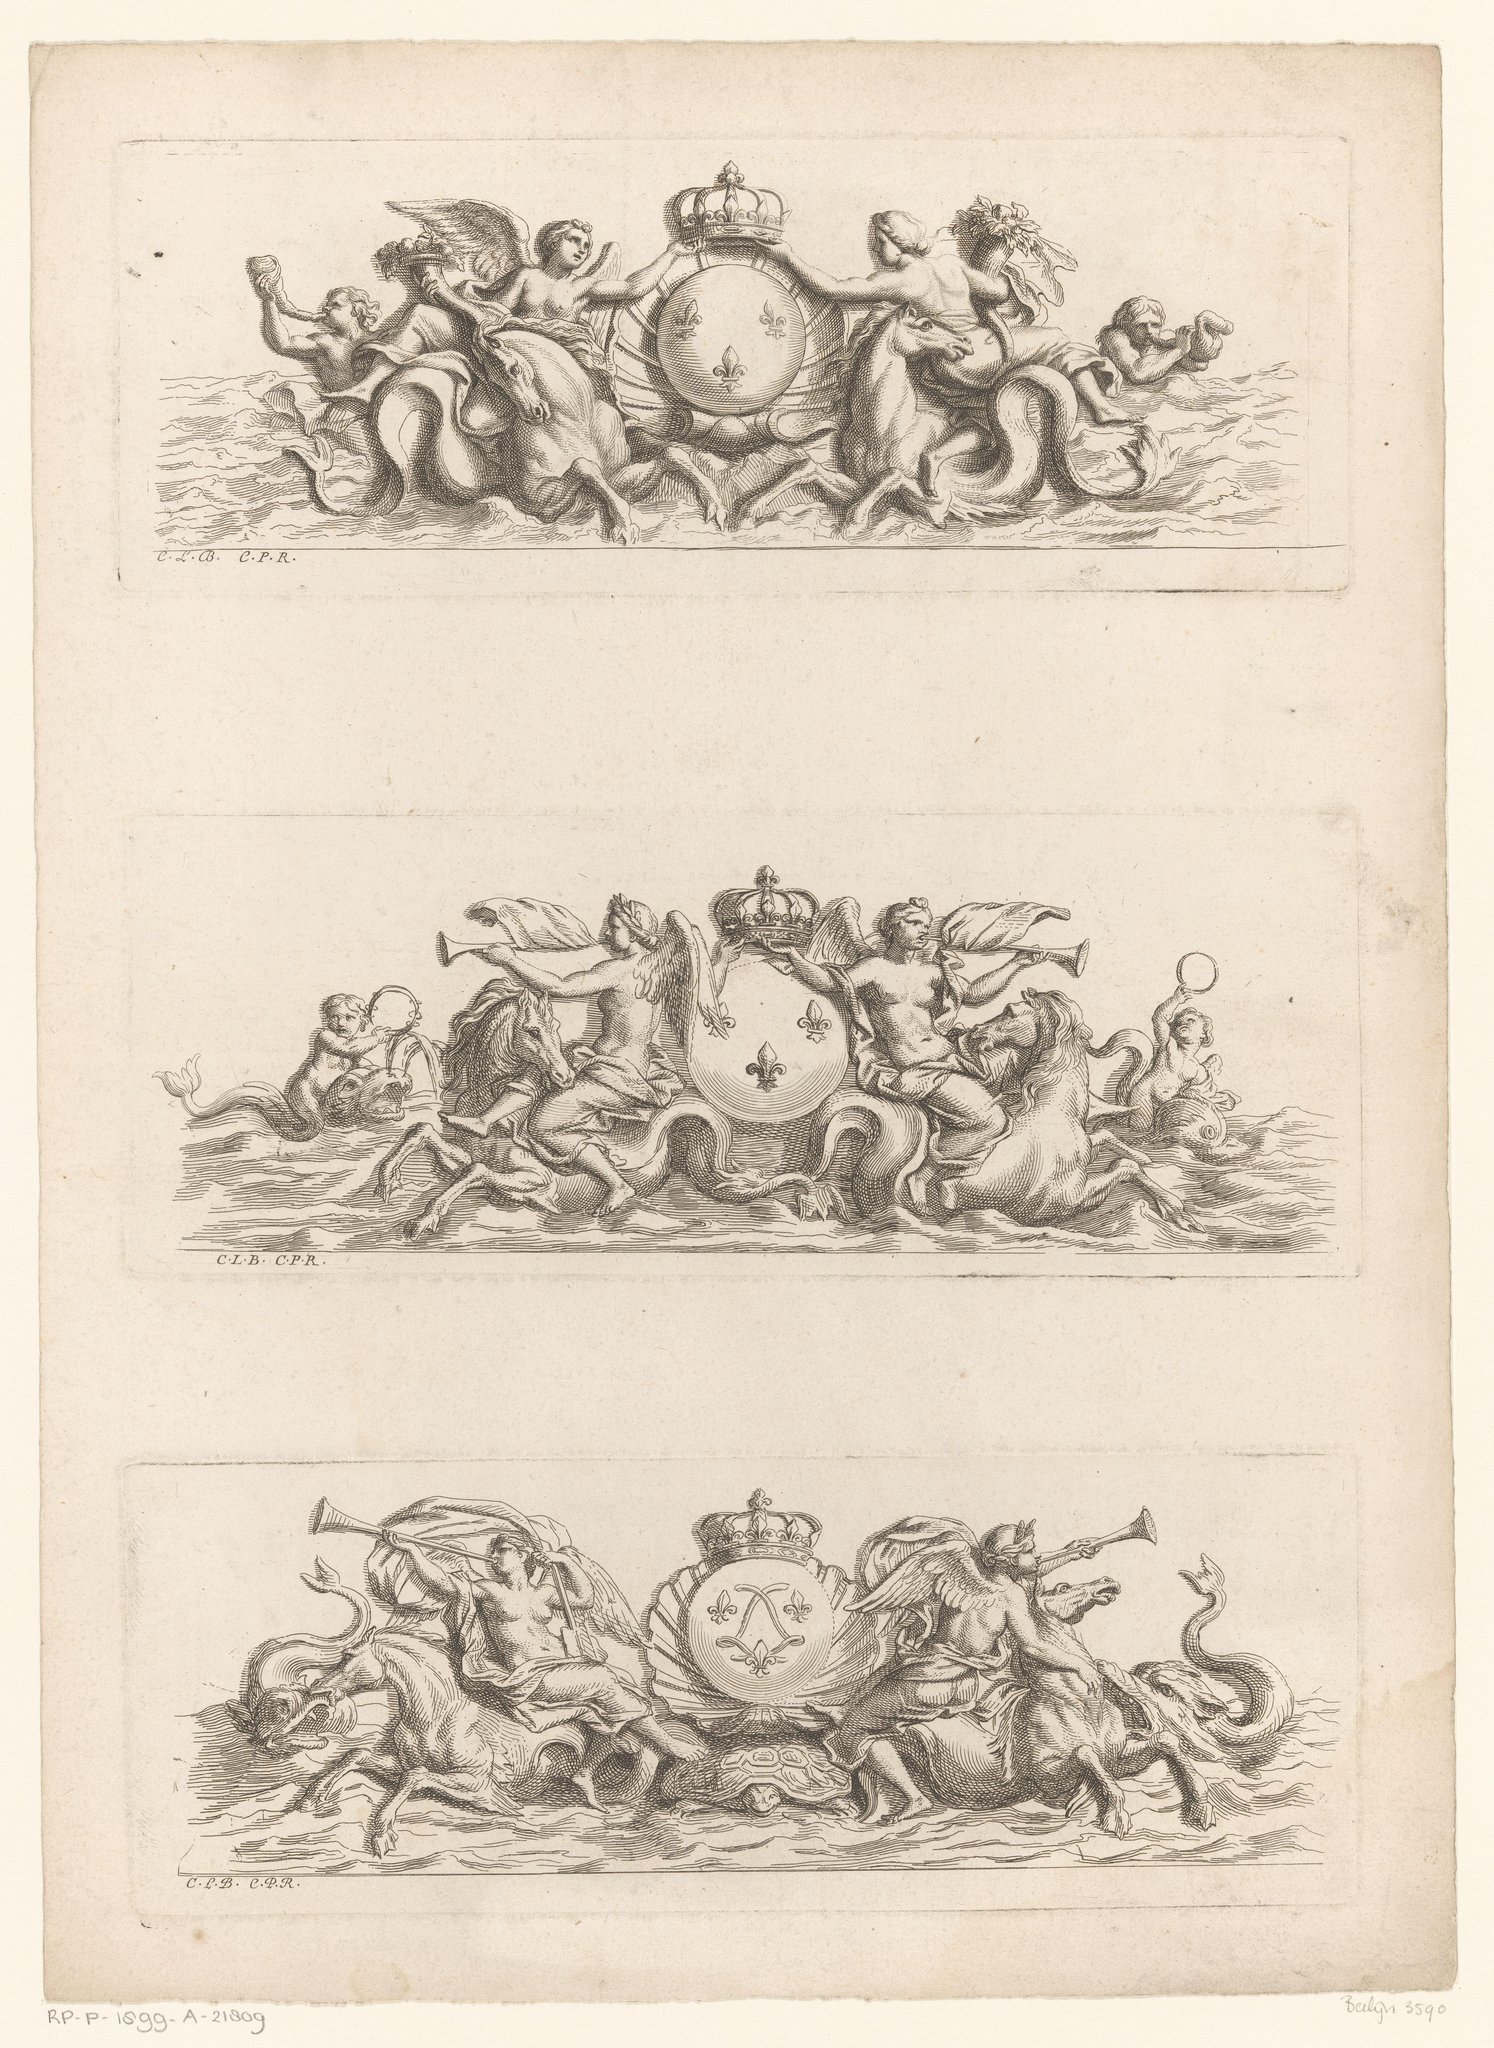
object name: ornament print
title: Recueil De Divers Desseins de Fontaines Et De Frises Maritimes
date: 1672-1686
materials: paper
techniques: etching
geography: paris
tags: coat of arms (as symbol of the state, etc.), angels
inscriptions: collector's mark: Lugt 2228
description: Drie friezen op een blad. Boven: Gekroond wapen van Frankrijk in een schelp, geflankeerd door engelen met hoornen des overvloeds zittend op hippocampi en twee putti blazend op schelpen. Midden: Gekroond wapen van Frankrijk in een schelp, geflankeerd door engelen met bazuinen, zittend op hippocampi en twee putti op dolfijnen. Onder: Gekroond wapen van Frankrijk in een schelp, geflankeerd door engelen met bazuinen zittend op hippocampi en twee dolfijnen.